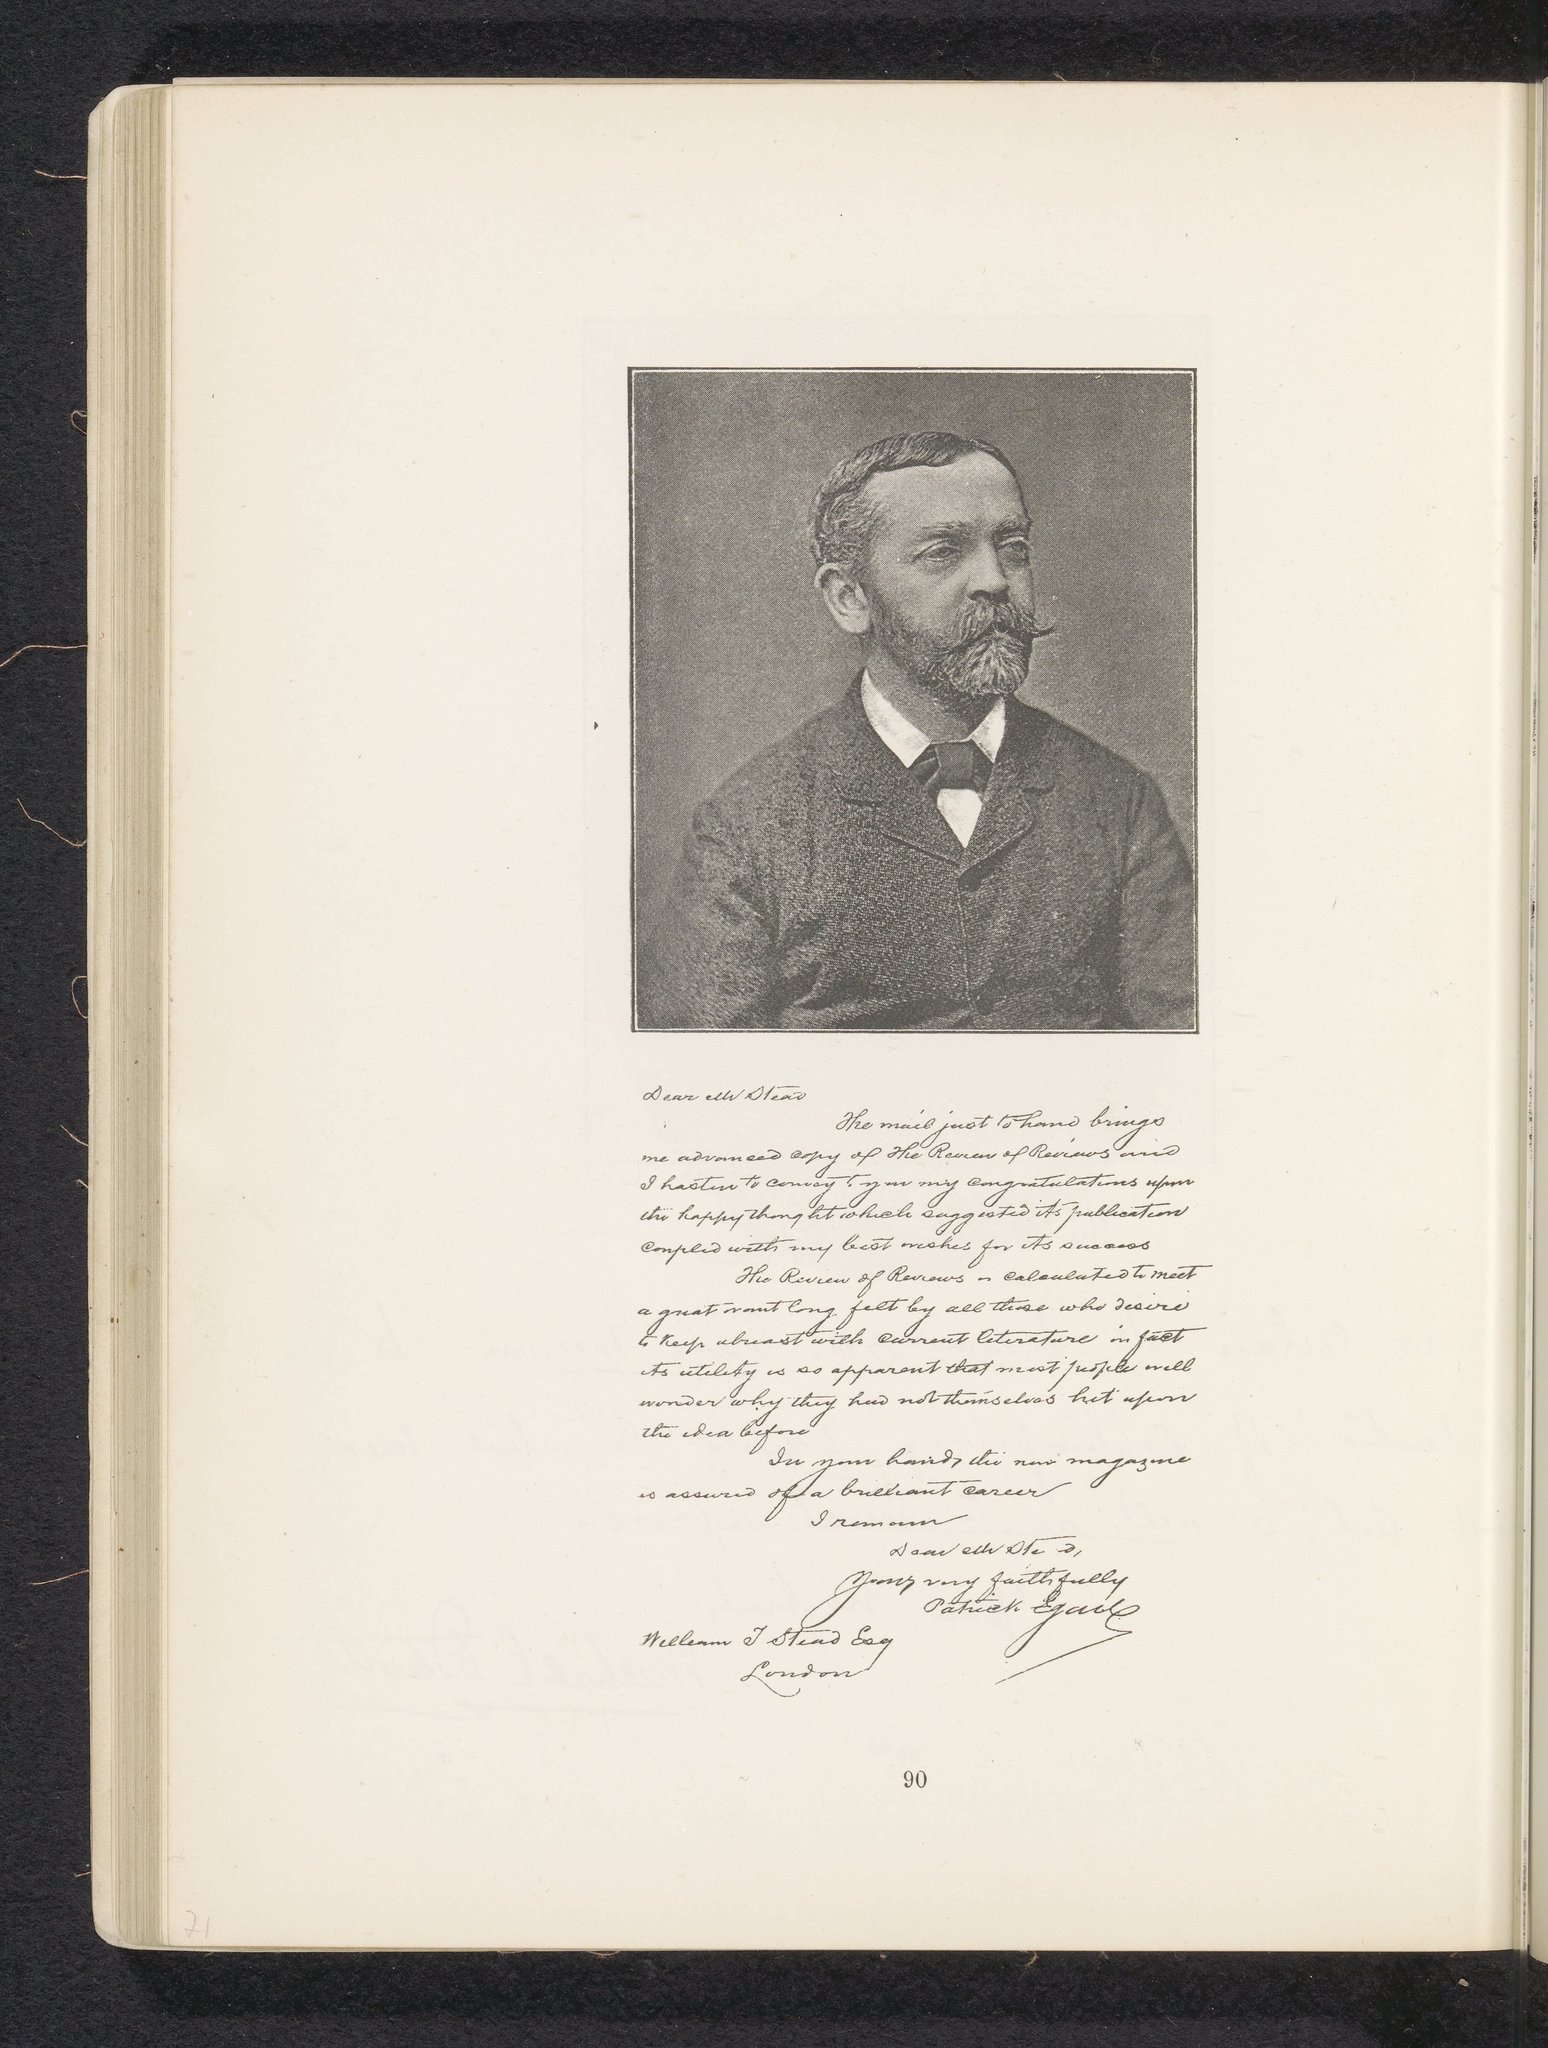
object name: photomechanical print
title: Portret van Patrick Egan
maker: Anonymous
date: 1881-1891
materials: paper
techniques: autotype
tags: politician, e.g. party leader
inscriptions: inscription